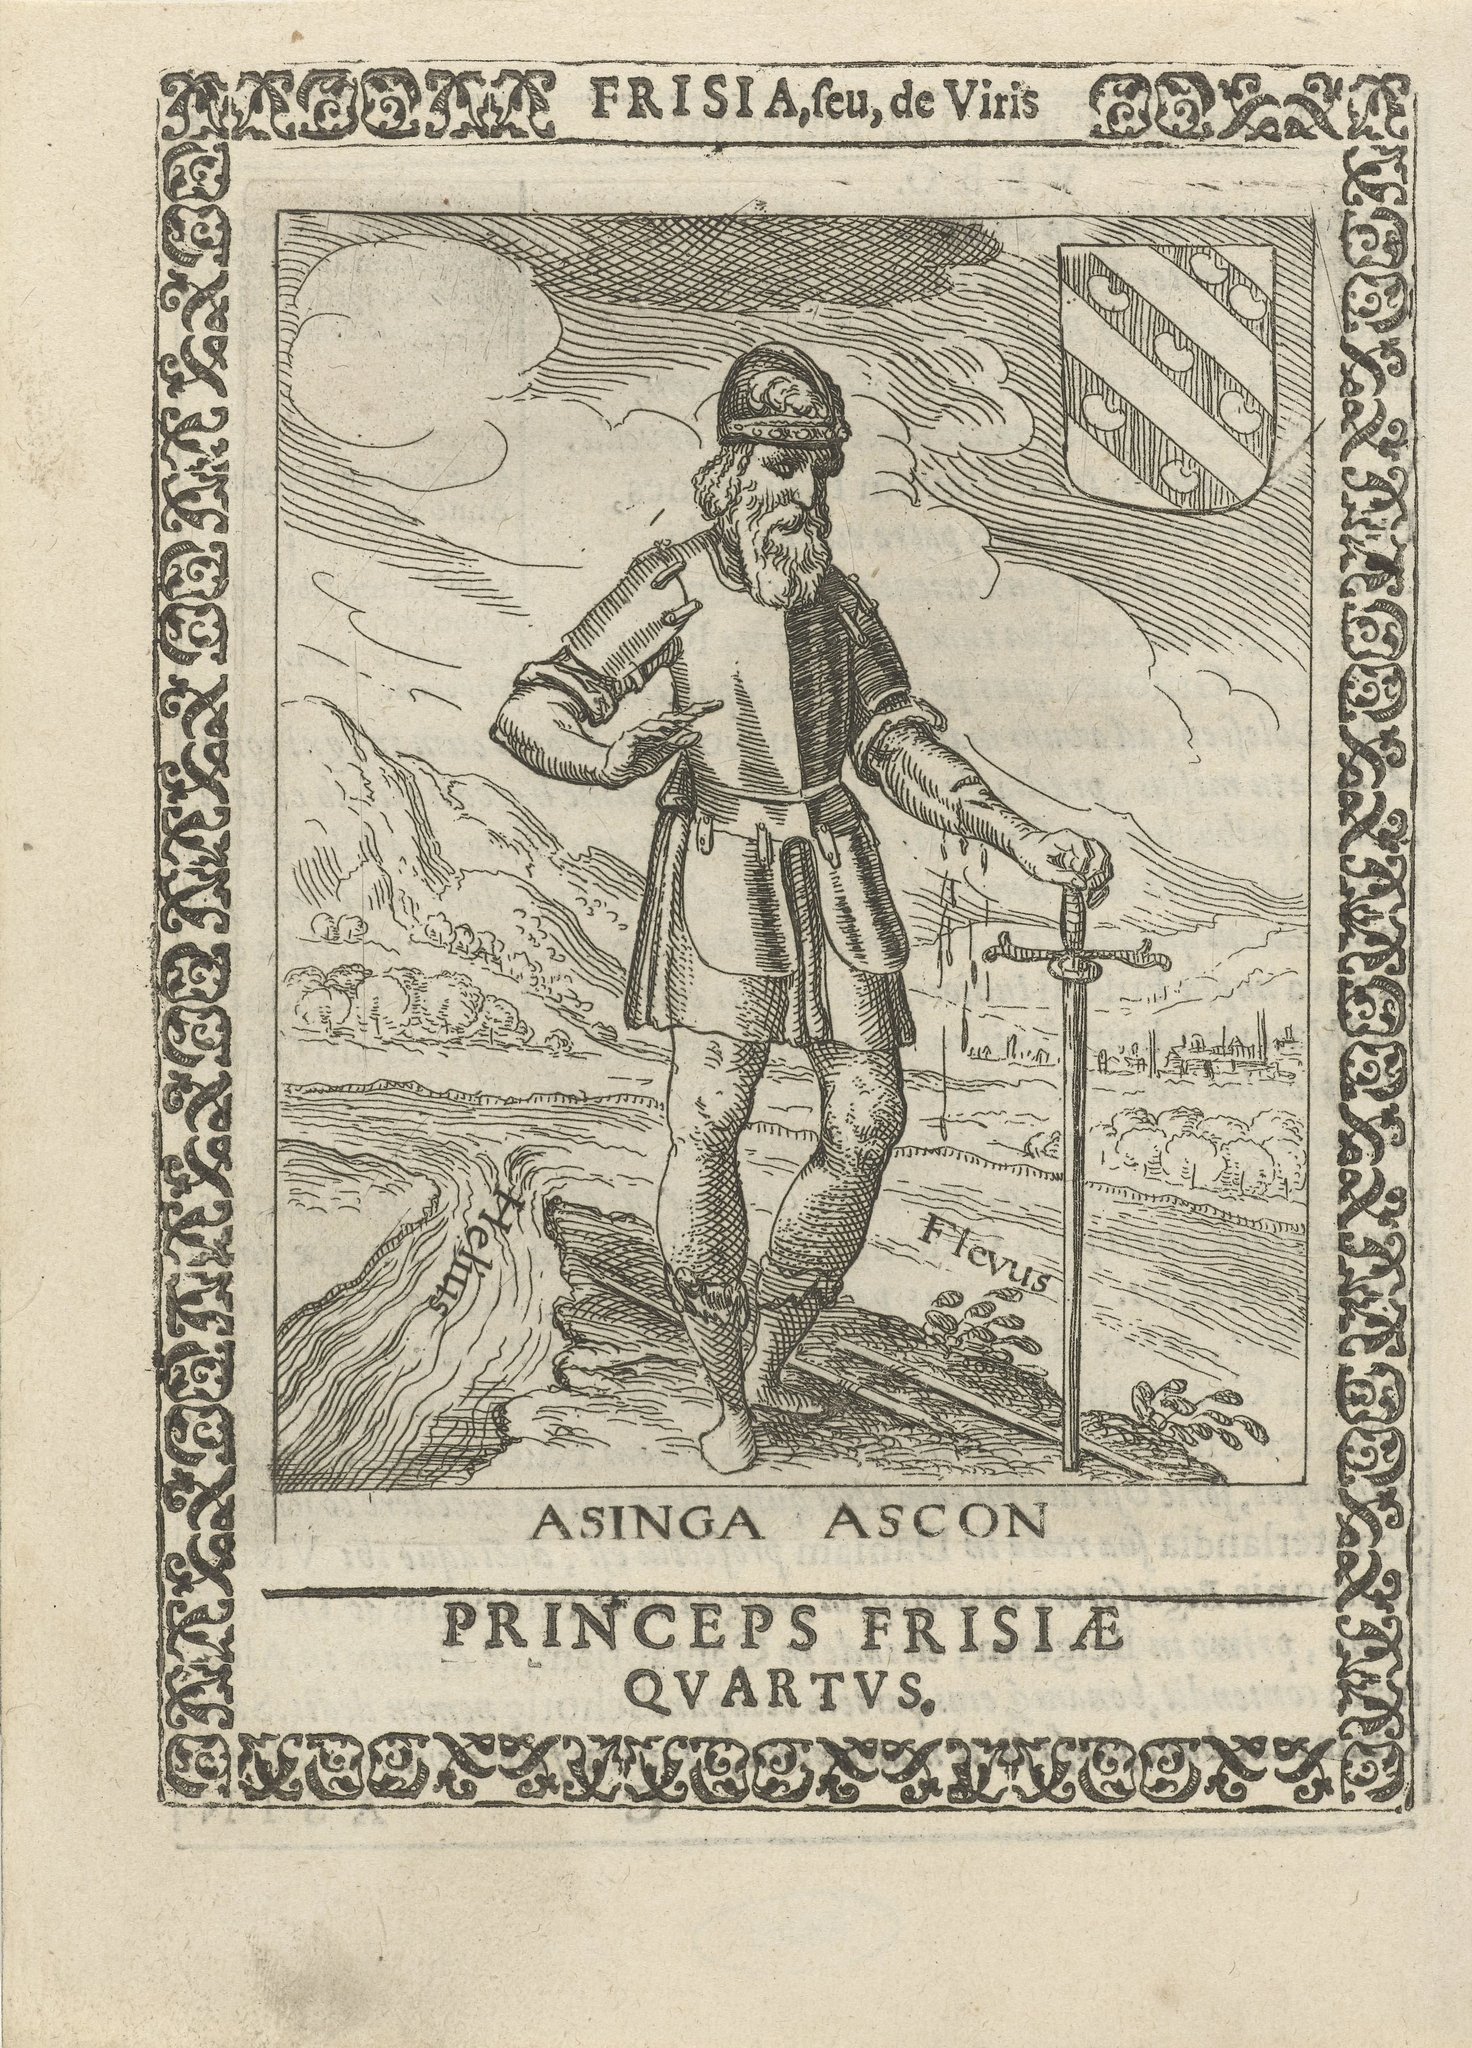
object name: print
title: Frisia, sev, de Viris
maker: pieter feddes van harlingen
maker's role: painter, print maker, publisher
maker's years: 1586-1623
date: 1618-1620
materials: paper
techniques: etching, letterpress printing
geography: friesland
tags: ruler, sovereign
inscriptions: collector's mark: Lugt 2228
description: Asinga Ascon, vierde prins der Friezen. Staande ten voeten uit, zwaard in de hand. Op de achtergrond de rivier Flevus Hellius. In een ornamentale omlijsting. Illustratie, met tekst op achterzijde, afkomstig uit het boek: Frisia seu de viris rebusque Frisiae illustribus libri duo.